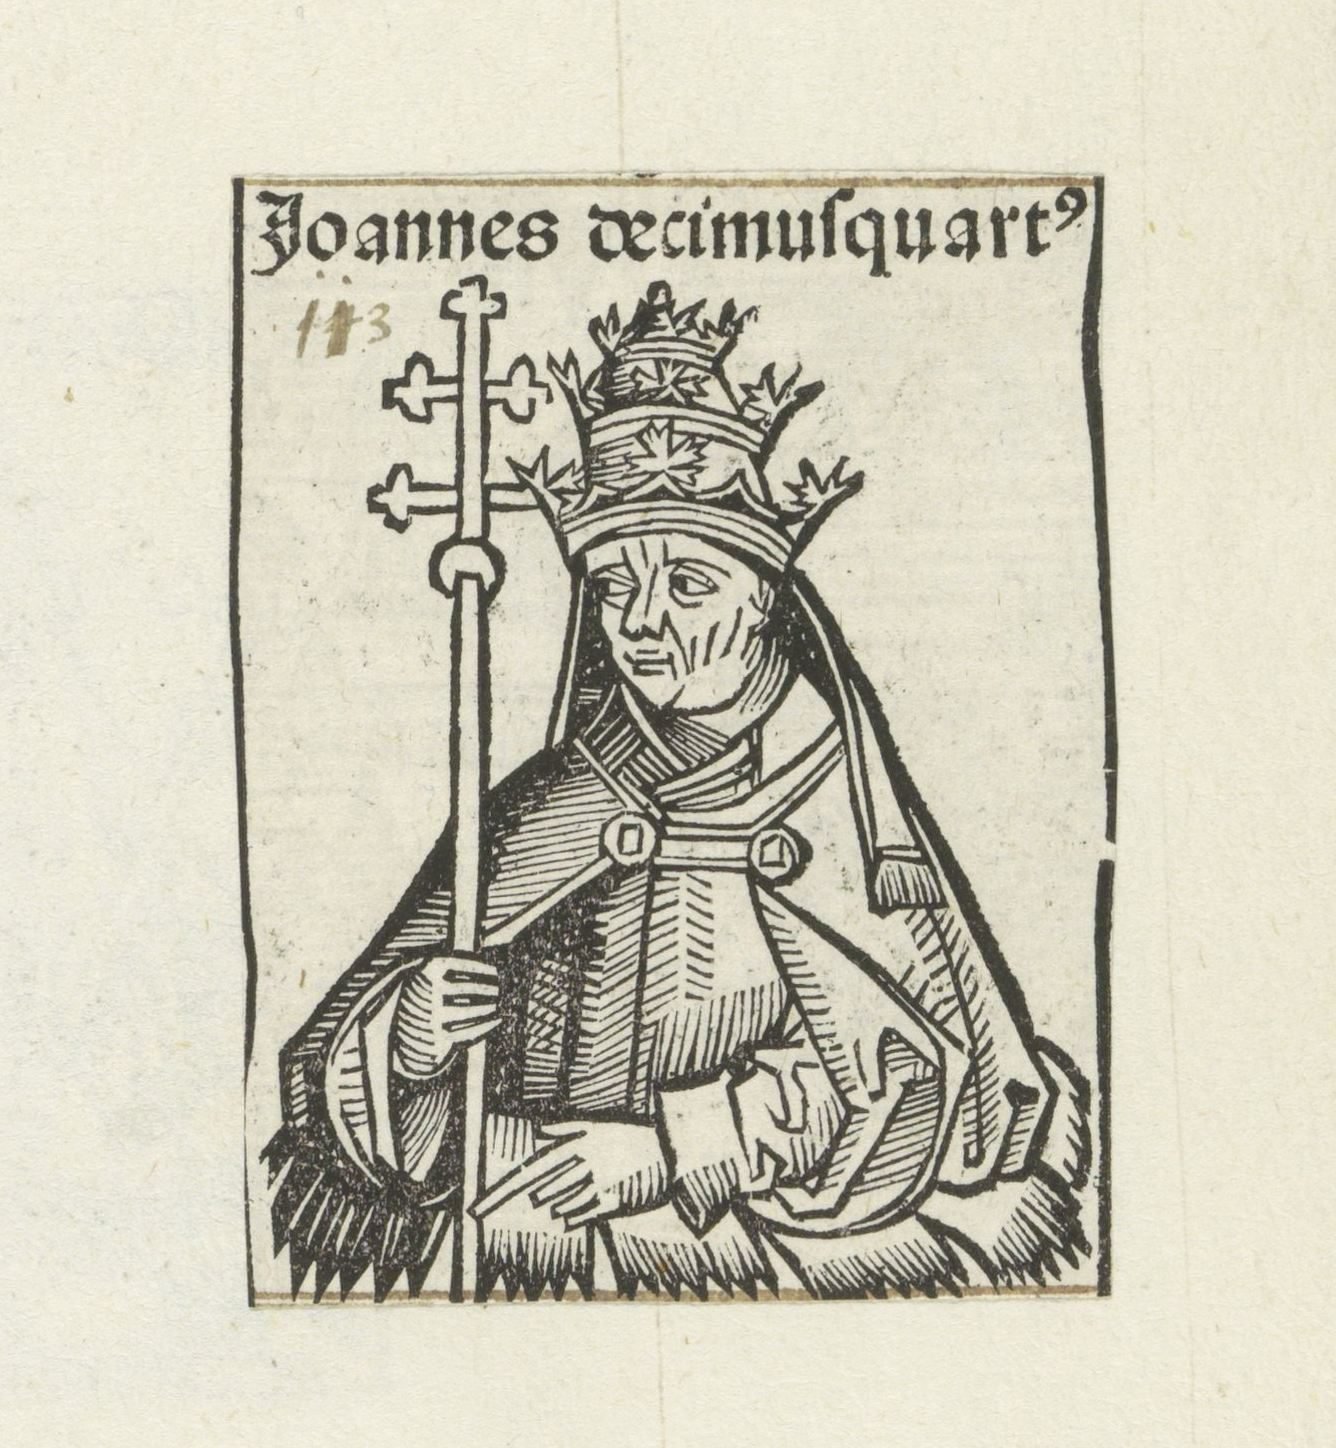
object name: album leaf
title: Joannes decimusquart[us]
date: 1493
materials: paper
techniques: letterpress printing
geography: nuremberg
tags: pope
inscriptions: inscription: ‘113’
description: Een bloemkelk met een paus. Hij draagt een tiara en heeft een staf met een dubbel kruis in zijn handen. De voorstelling is onderdeel van de opeenvolging pausen in de Liber Chronicarum. De tekst identificeert de man als Johannes XIV. De prent maakt deel uit van een album.